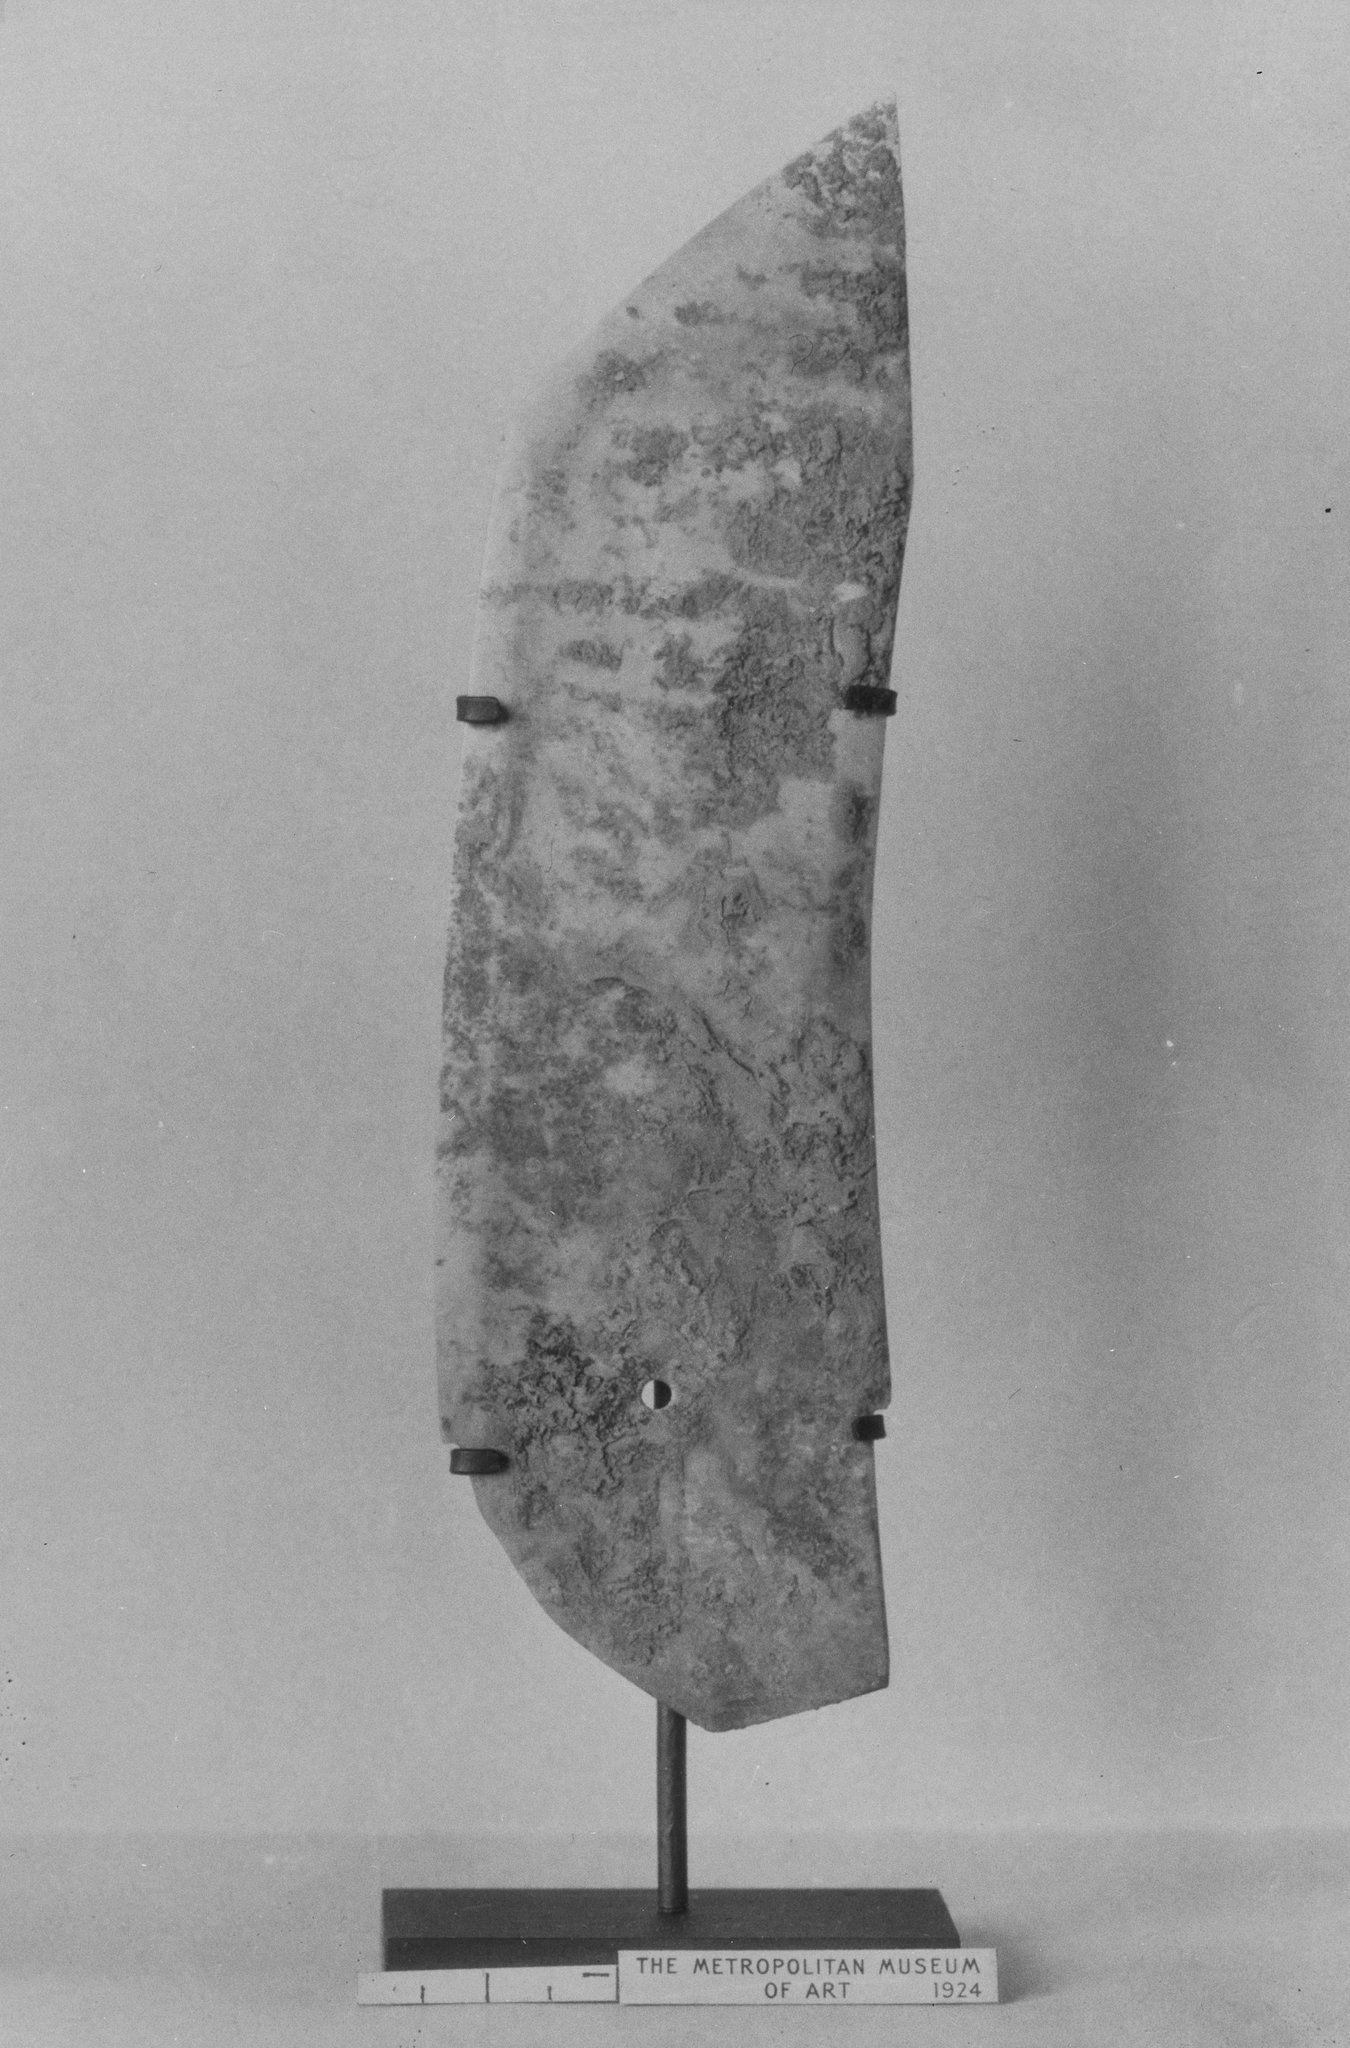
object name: dagger ax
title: Ceremonial dagger-ax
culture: chinese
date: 1750-1100 BCE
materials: jade